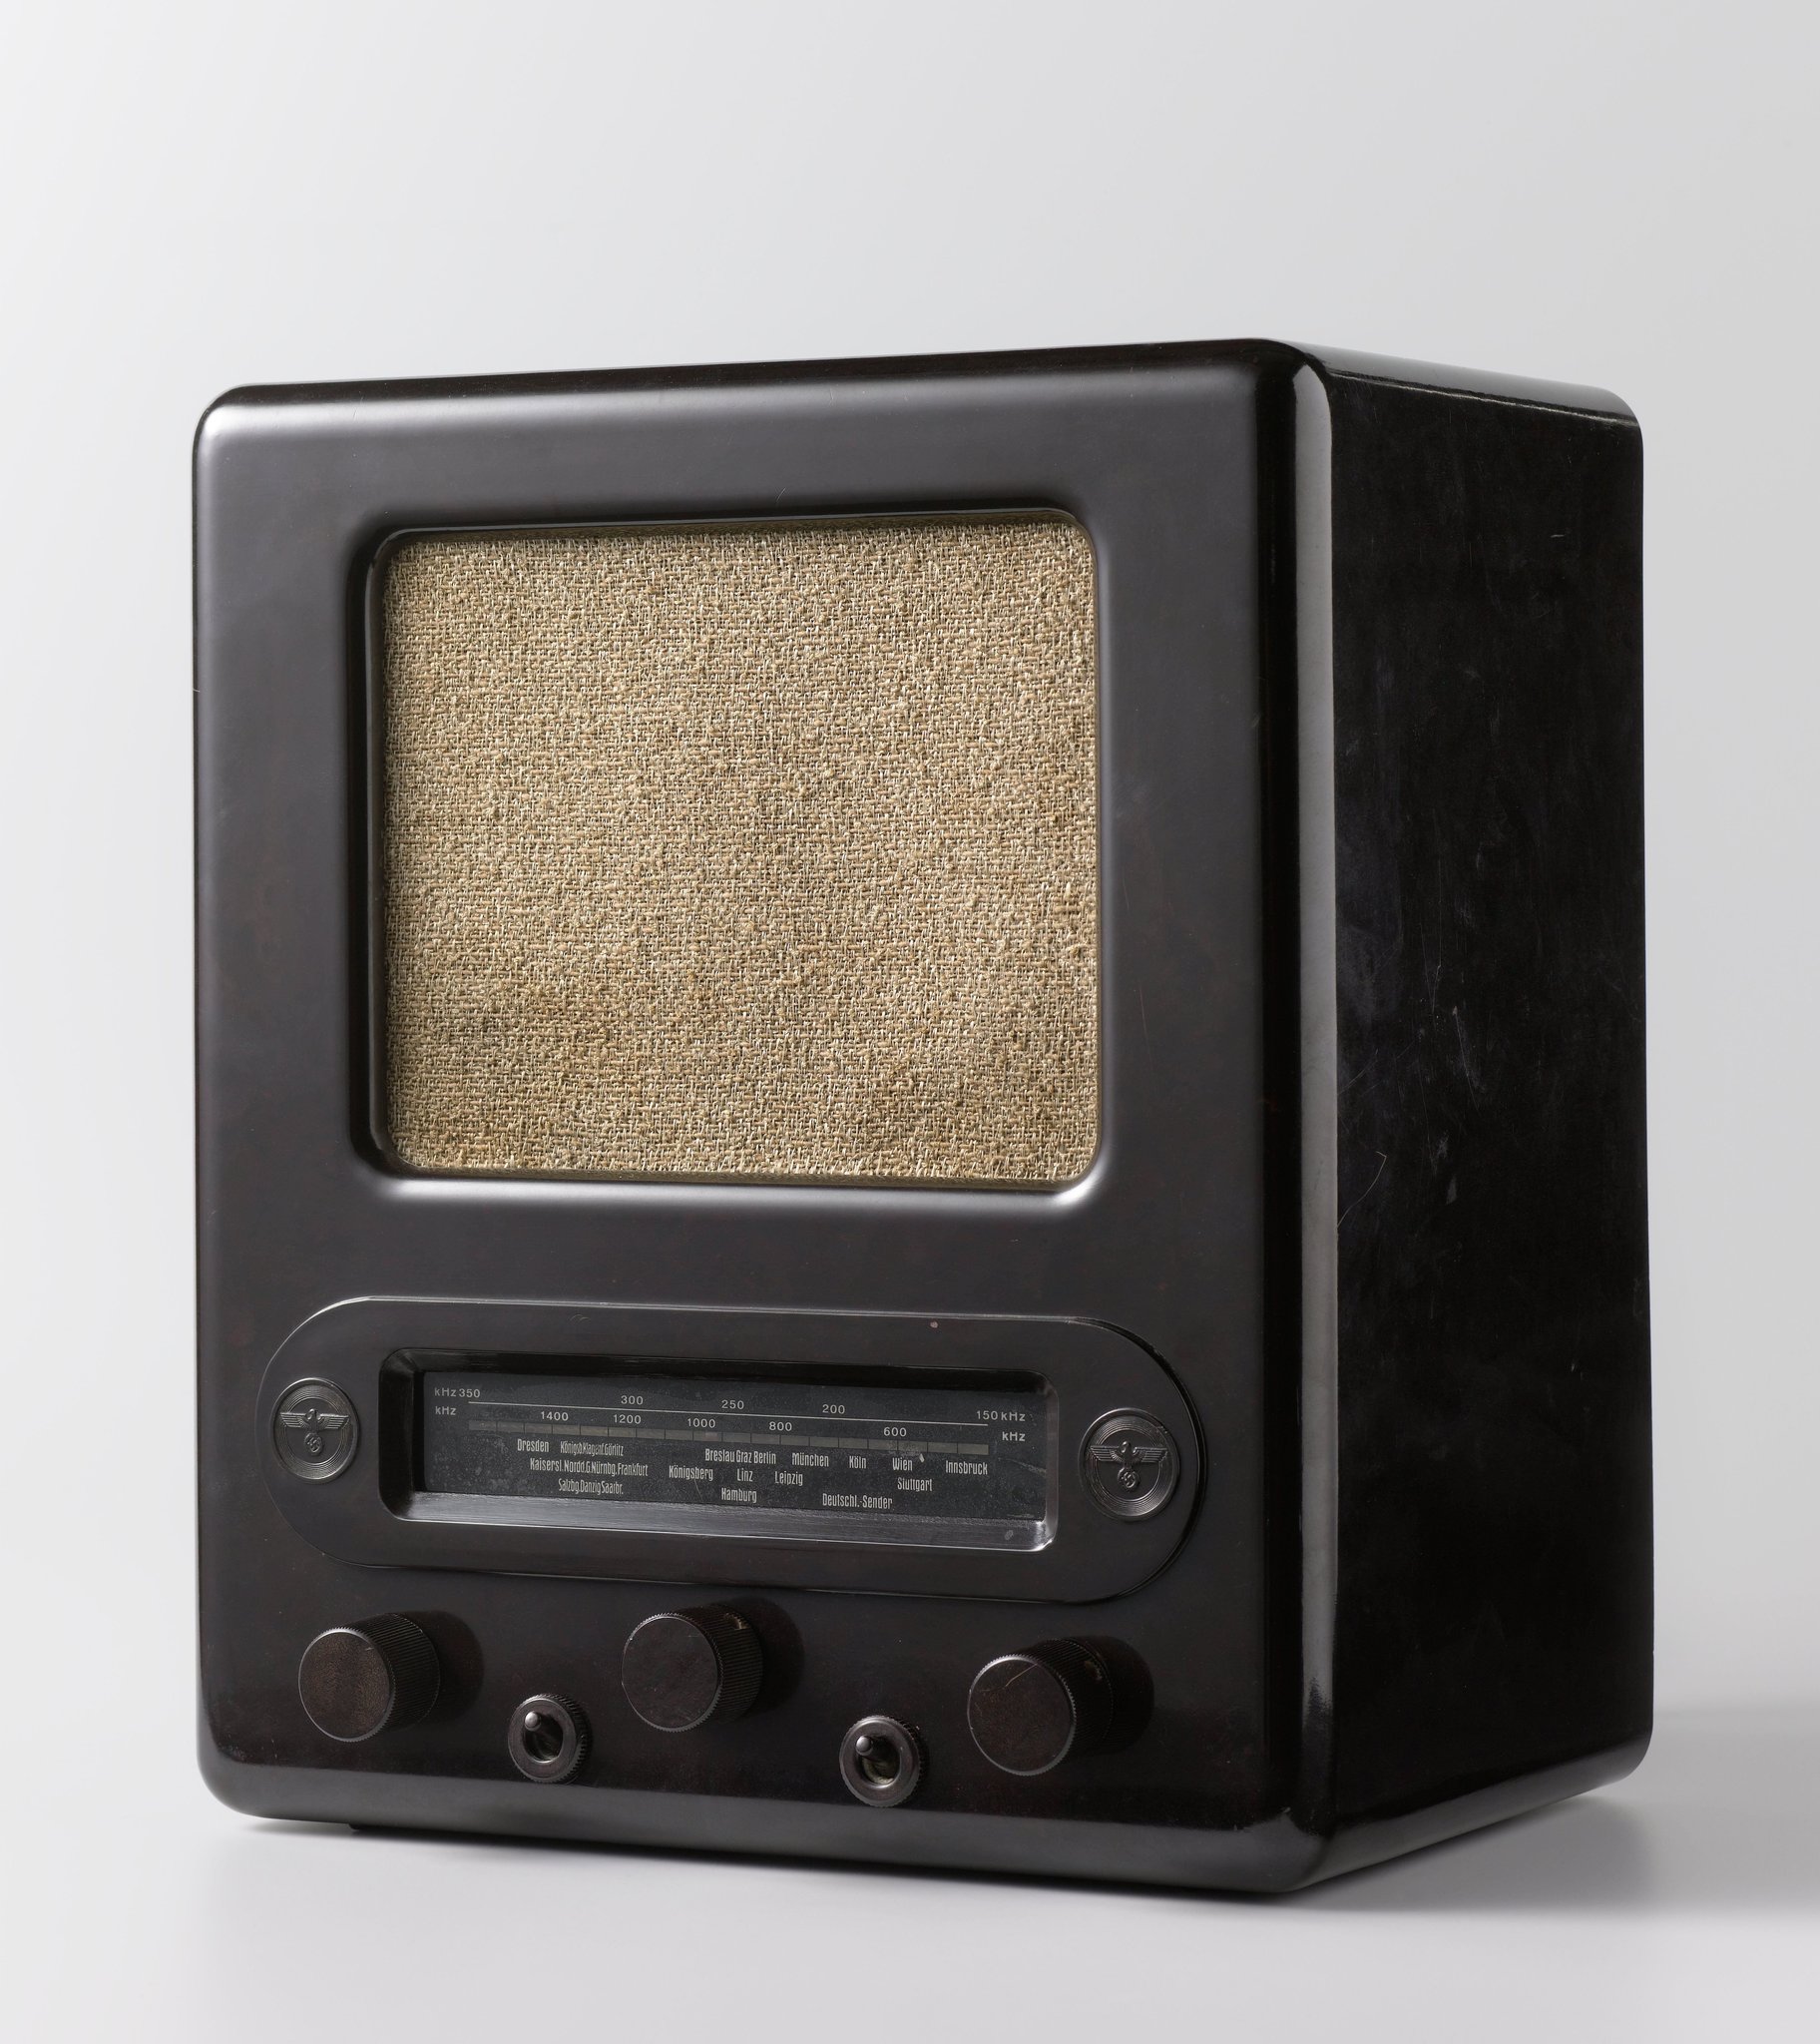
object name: radio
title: Volksempfänger VE 301 Dyn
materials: bakelite, cardboard, textile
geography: berlin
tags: radio, wireless, radio broadcasting, berlin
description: In the 1930s this type of ‘people’s receiver’ served as a mouthpiece for Nazi ideology in millions of German households. On either side of the tuner display is an eagle with a swastika. The designation 301 refers to the day of Adolf Hitler’s assumption of power, namely 30 January 1933. Deutsche Philips Gesellschaft was a sister company of the Dutch electronics firm Philips, which found a large market in Germany.